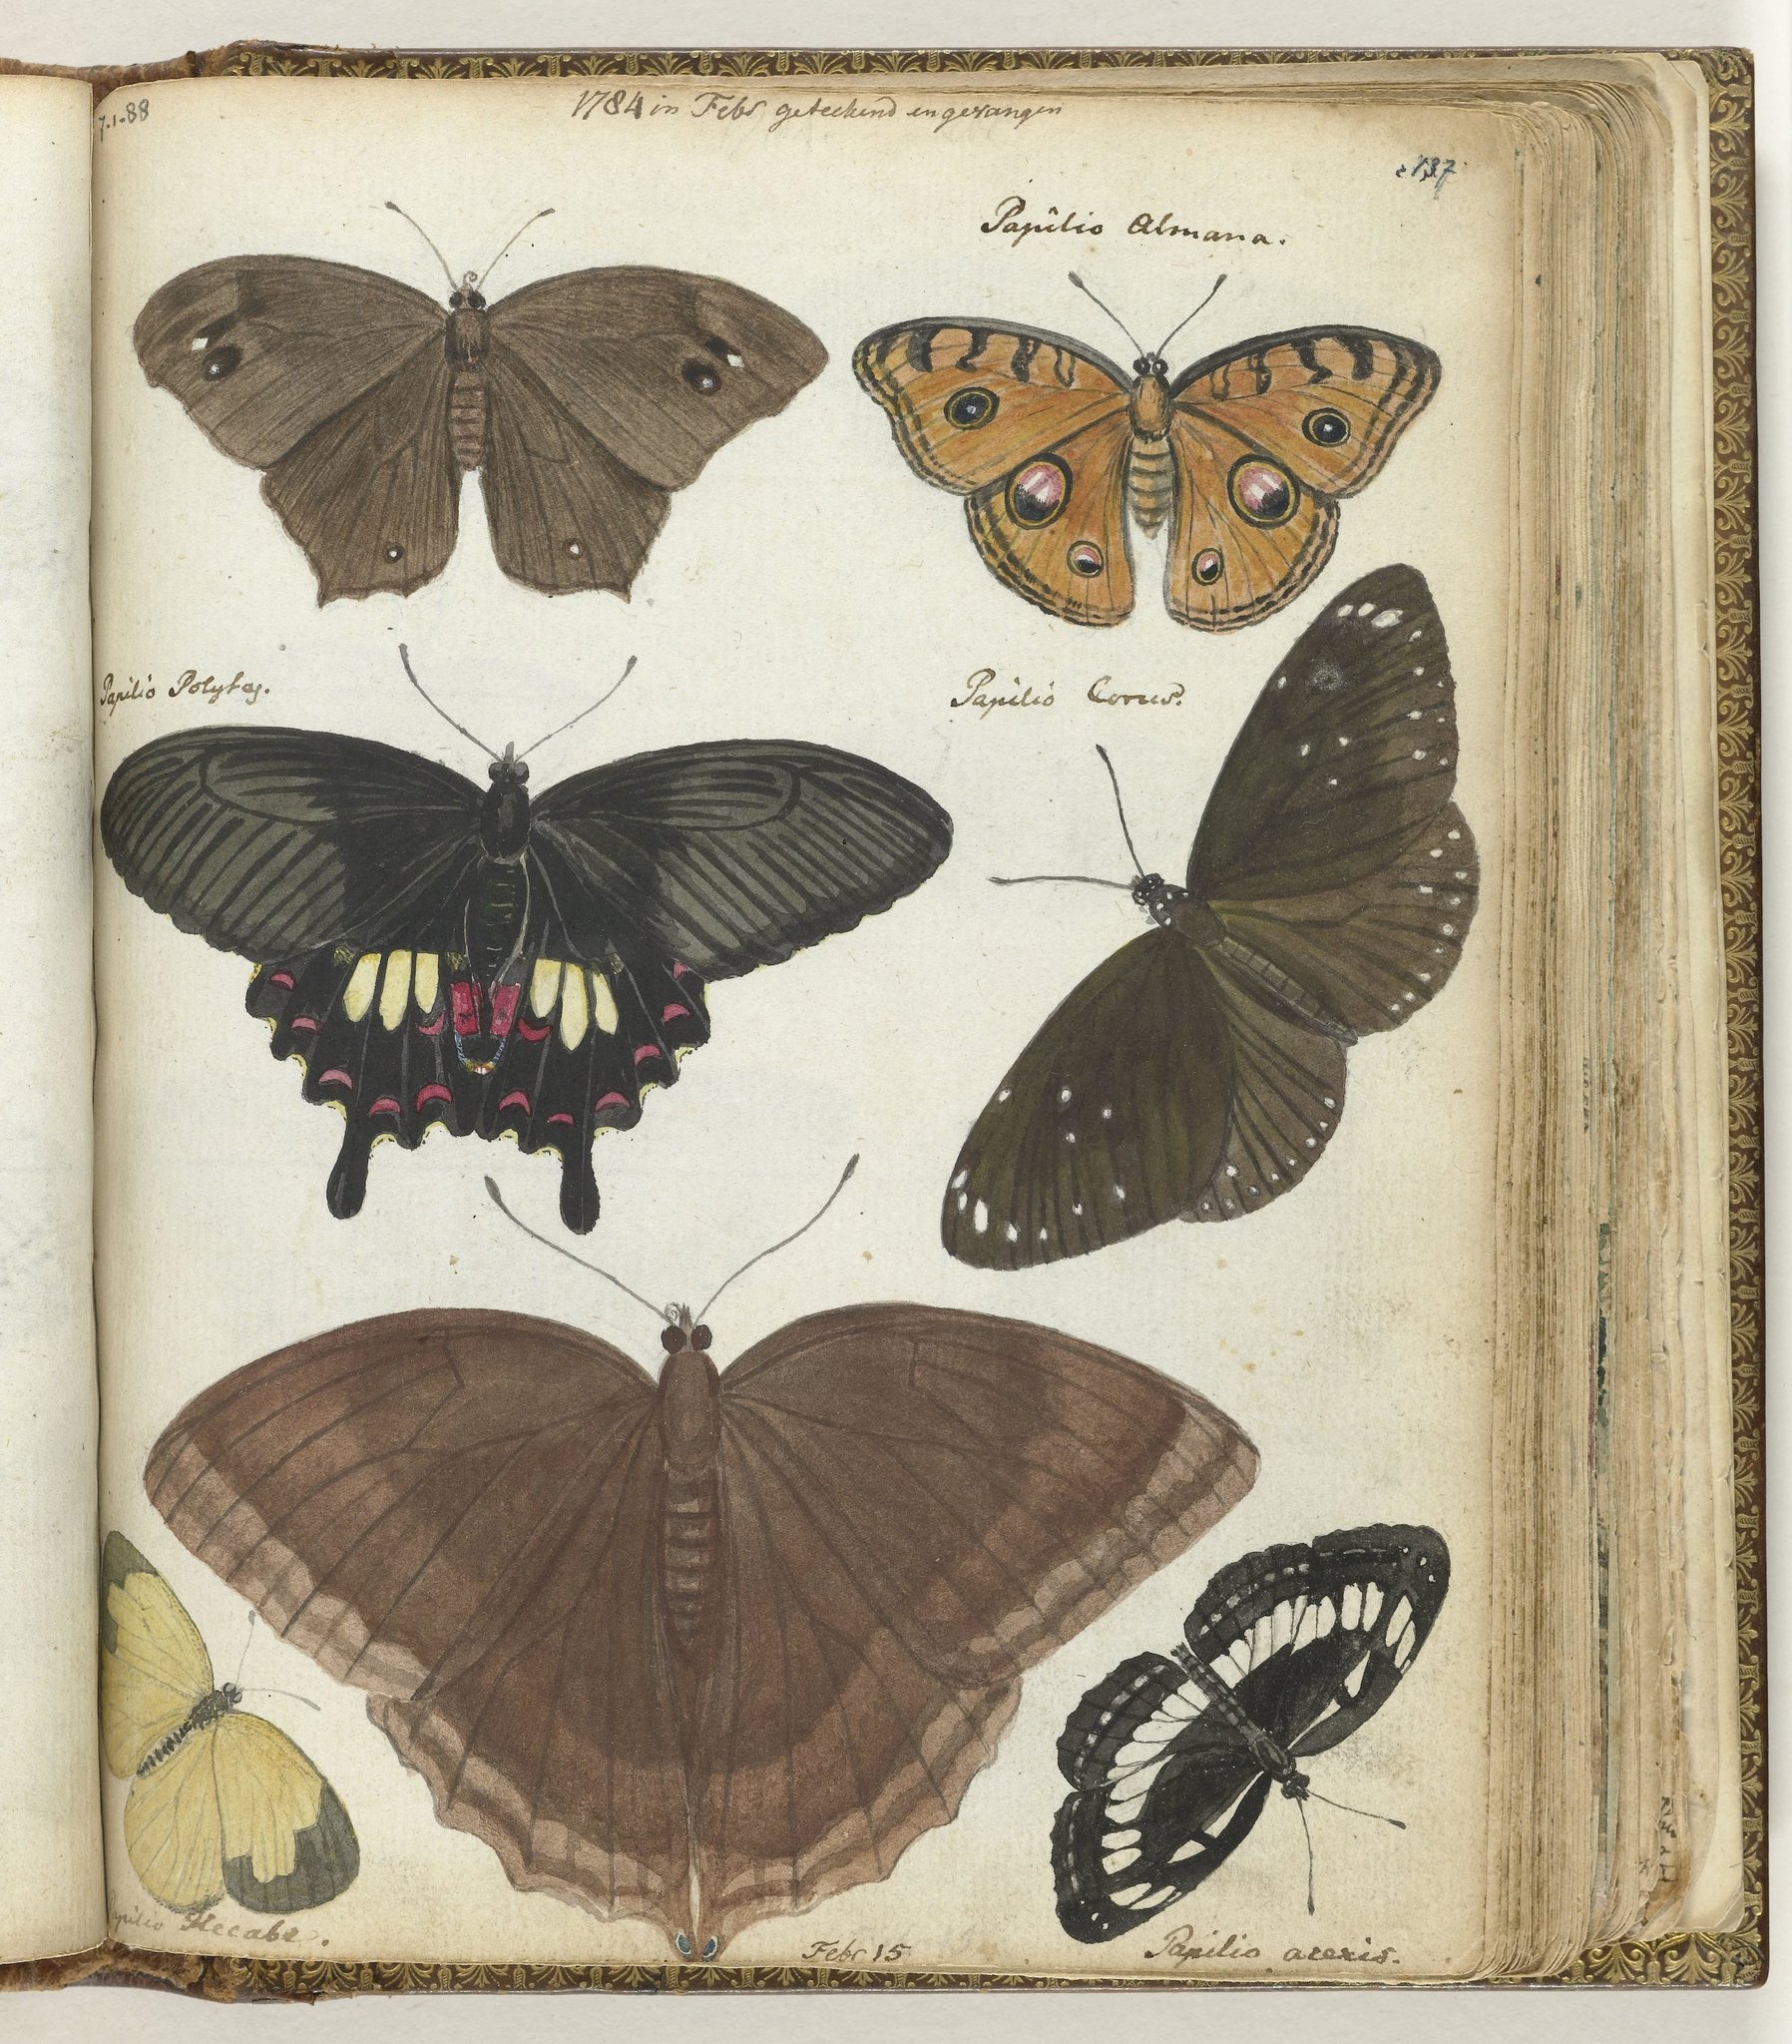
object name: drawing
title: Vlinders van Java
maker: jan brandes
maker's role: draughtsman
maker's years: 1743-1808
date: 1784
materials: paper, pencil, watercolor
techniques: brush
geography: jakarta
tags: insects: butterfly, java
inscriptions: inscription: ‘1784 in Febr geteekend en gevangen Papilio Almana. Papilio Polytas. Papilio Corus. Papilio Hecabe. Febr 15 Papilio aceris.’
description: Kleurtekening van een aantal Javaanse vlinders en motachtigen. Met opschrift. Onderdeel uit het schetsboek van Jan Brandes, dl. 1 (1808), p. 137.